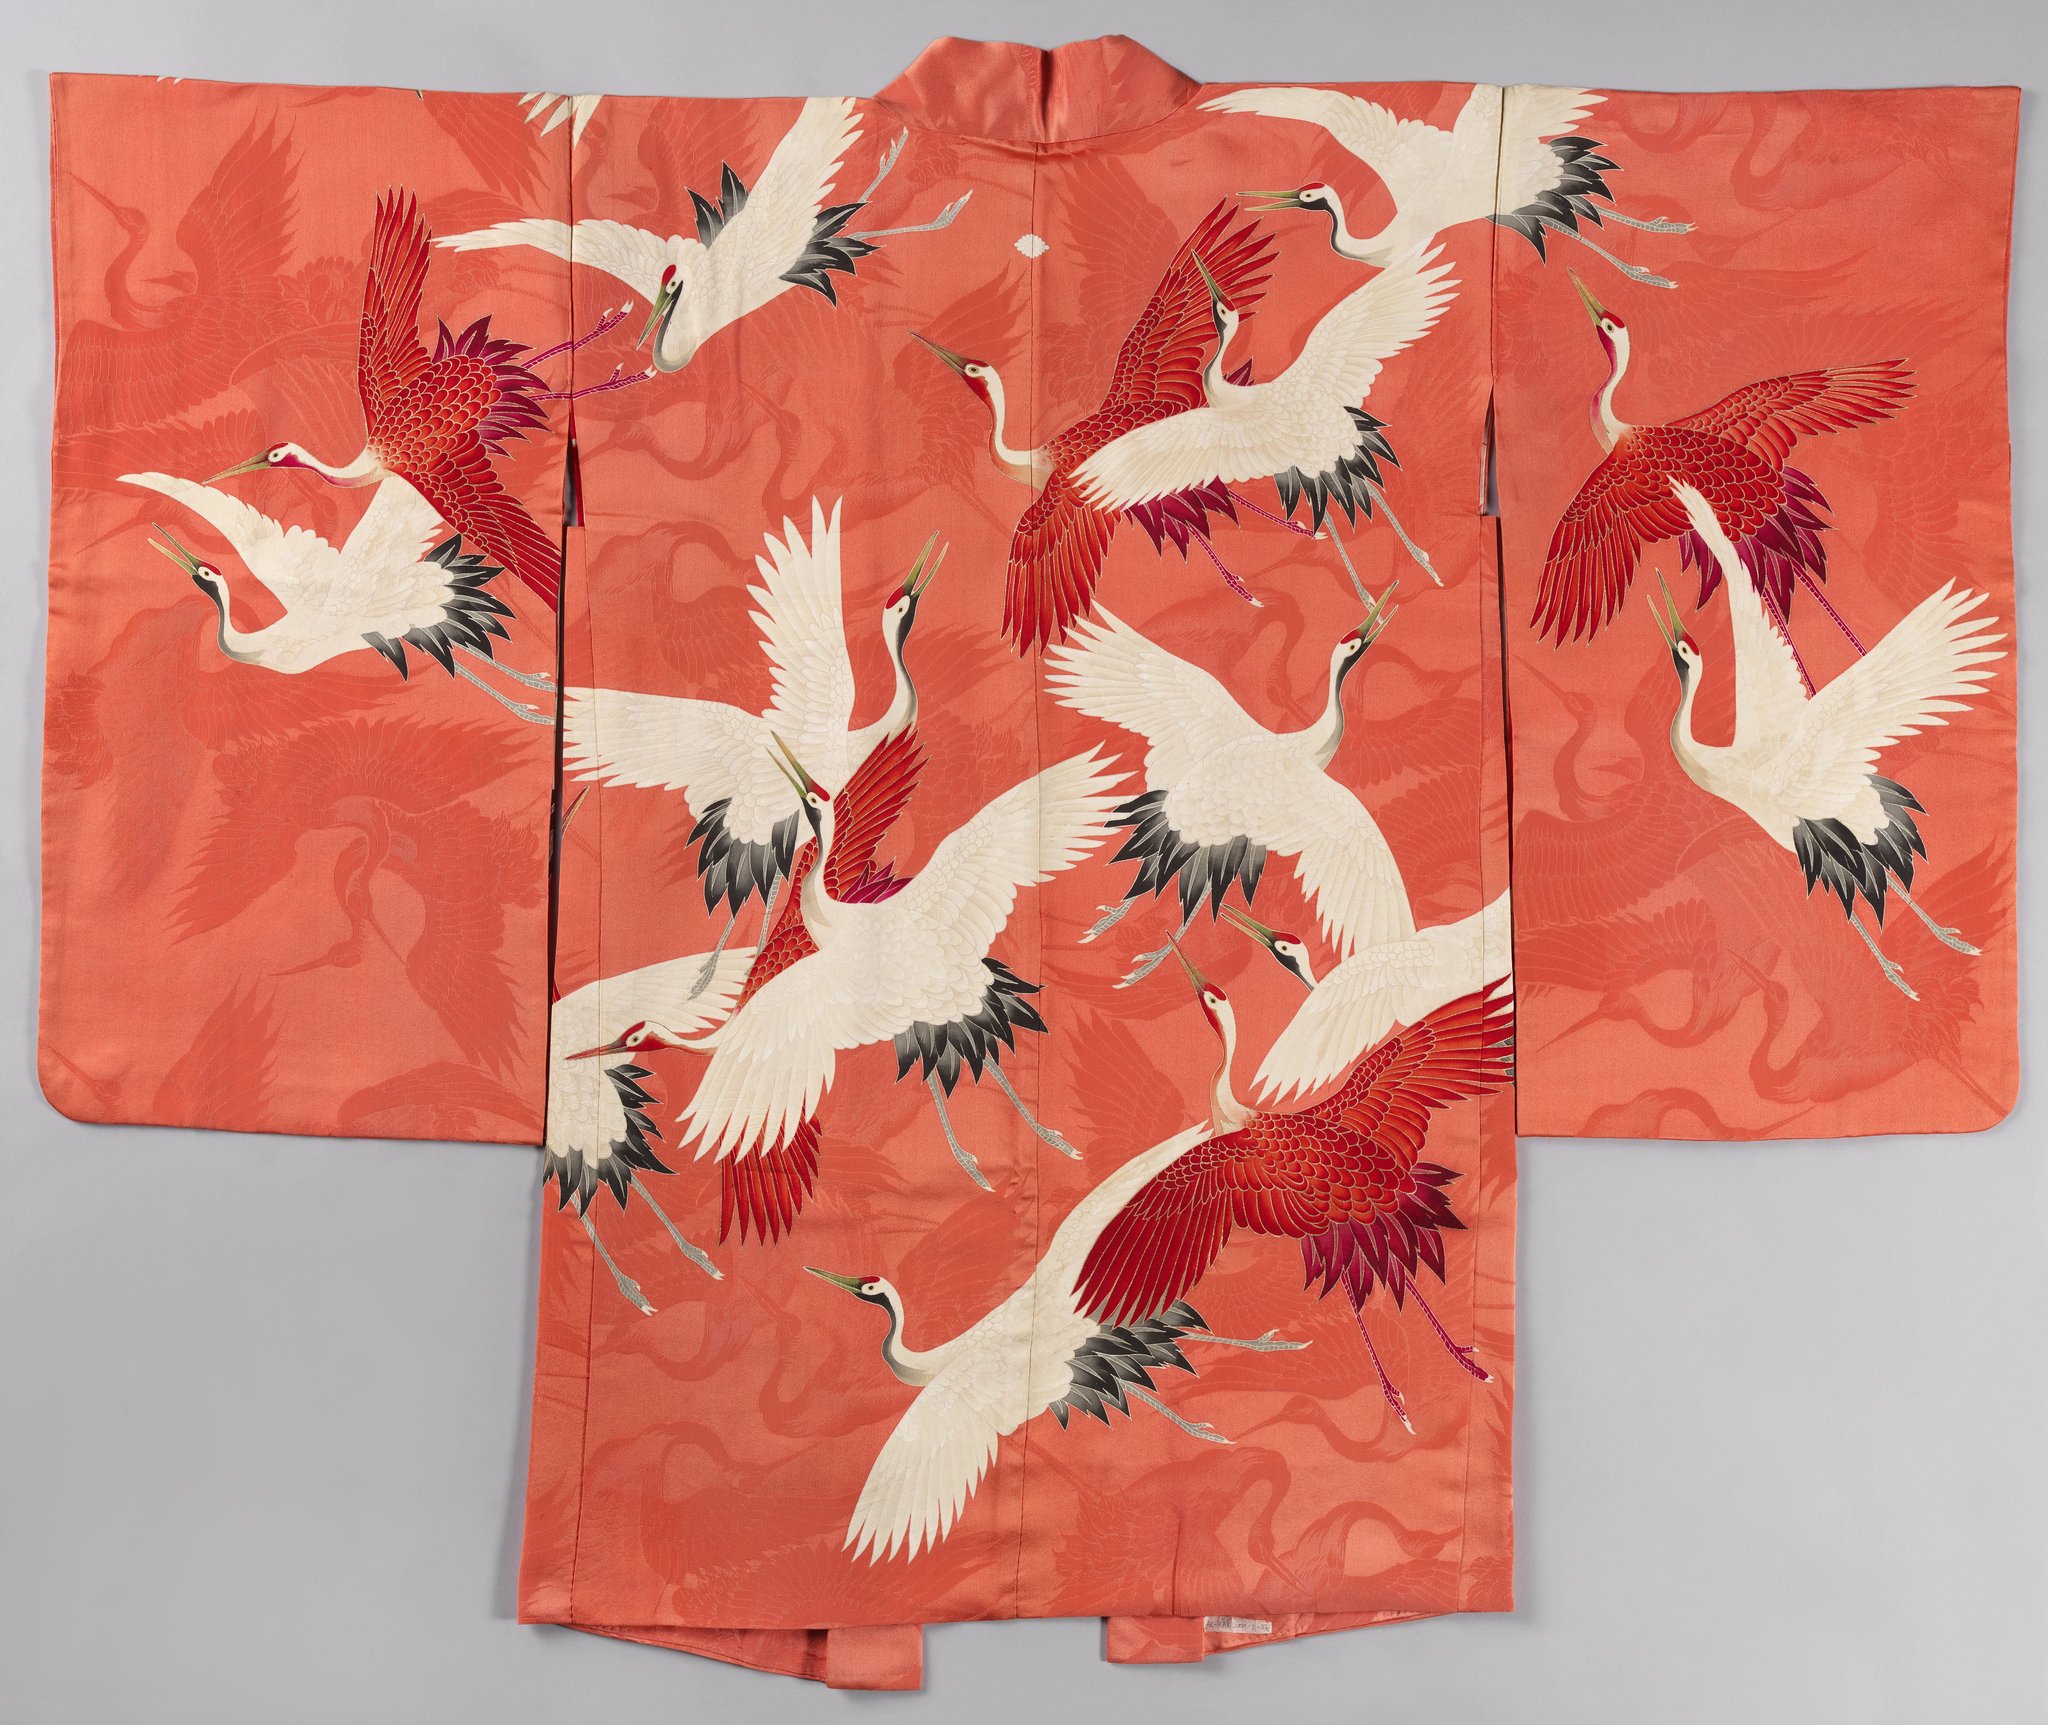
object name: kimono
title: Woman's Haori with White and Red Cranes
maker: Anonymous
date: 1920-1940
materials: silk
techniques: painting, weave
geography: japan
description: Haori voor een vrouw met een versiering over het hele vlak van witte en rode kraanvogels in vlucht, de voering over het hele vlak met witte origami kraanvogels. Roze zijde met een damast geweven decoratie van kraanvogels, buitenkant en voering met geschilderde yuzen decoratie en goudfolie. Enkel familiewapen (mon) van een gestileerd bloemmotief (hanabishi).